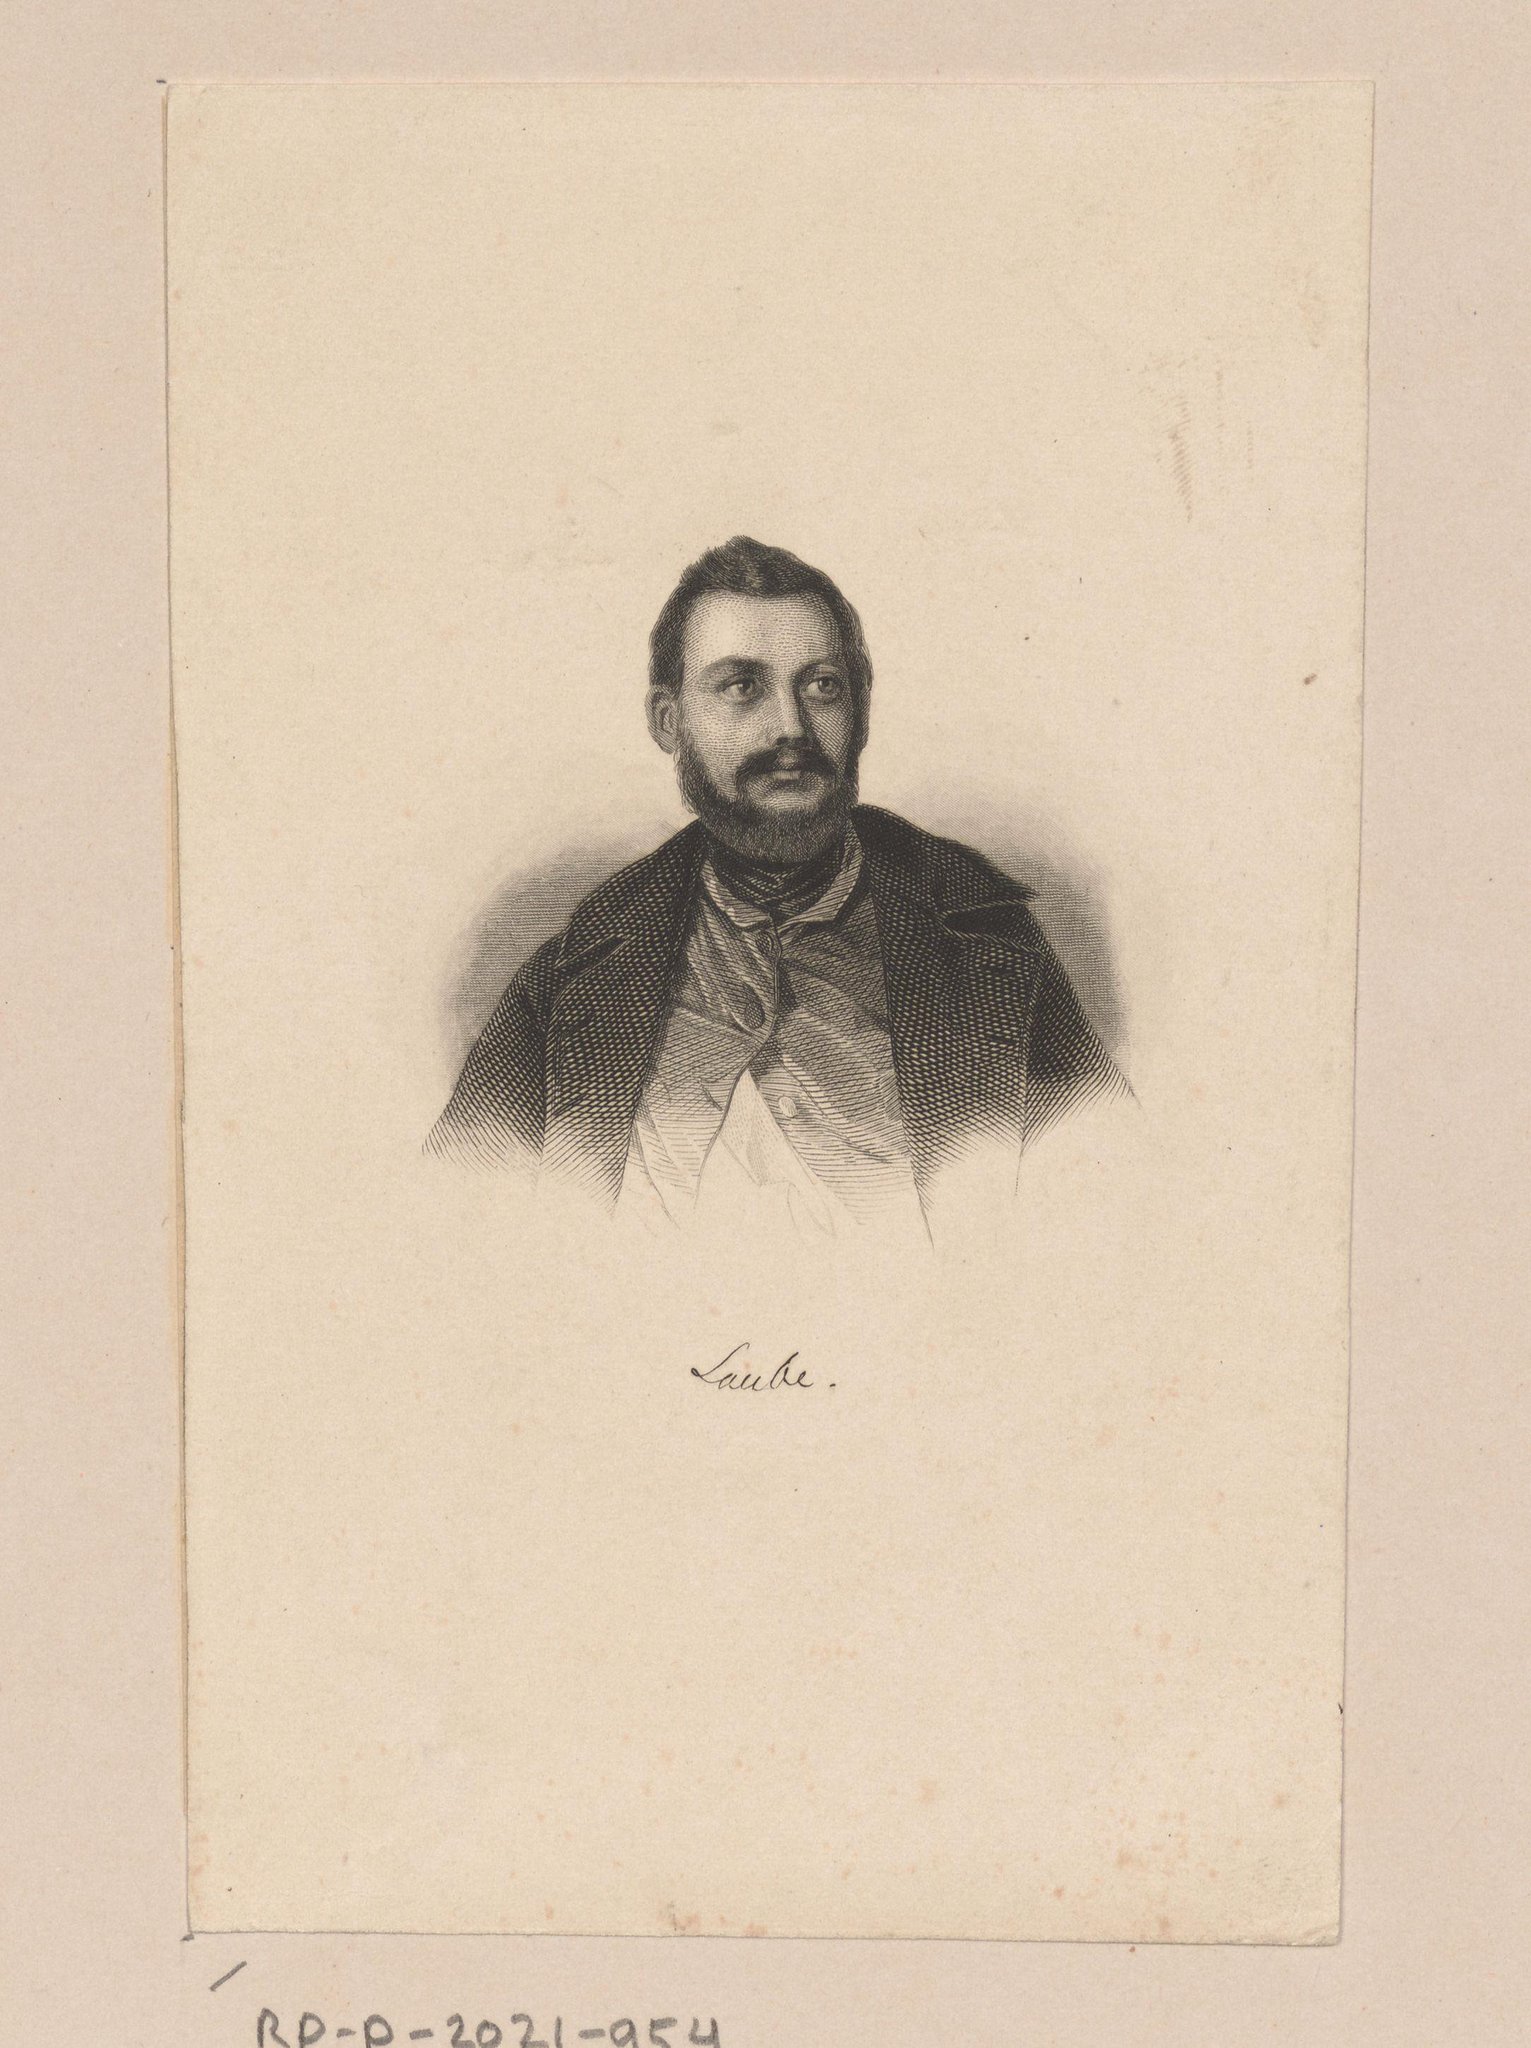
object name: print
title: Portret van Heinrich Laube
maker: Anonymous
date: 1845-1899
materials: paper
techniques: engraving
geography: germany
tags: vienna, historical persons, portrait of a writer